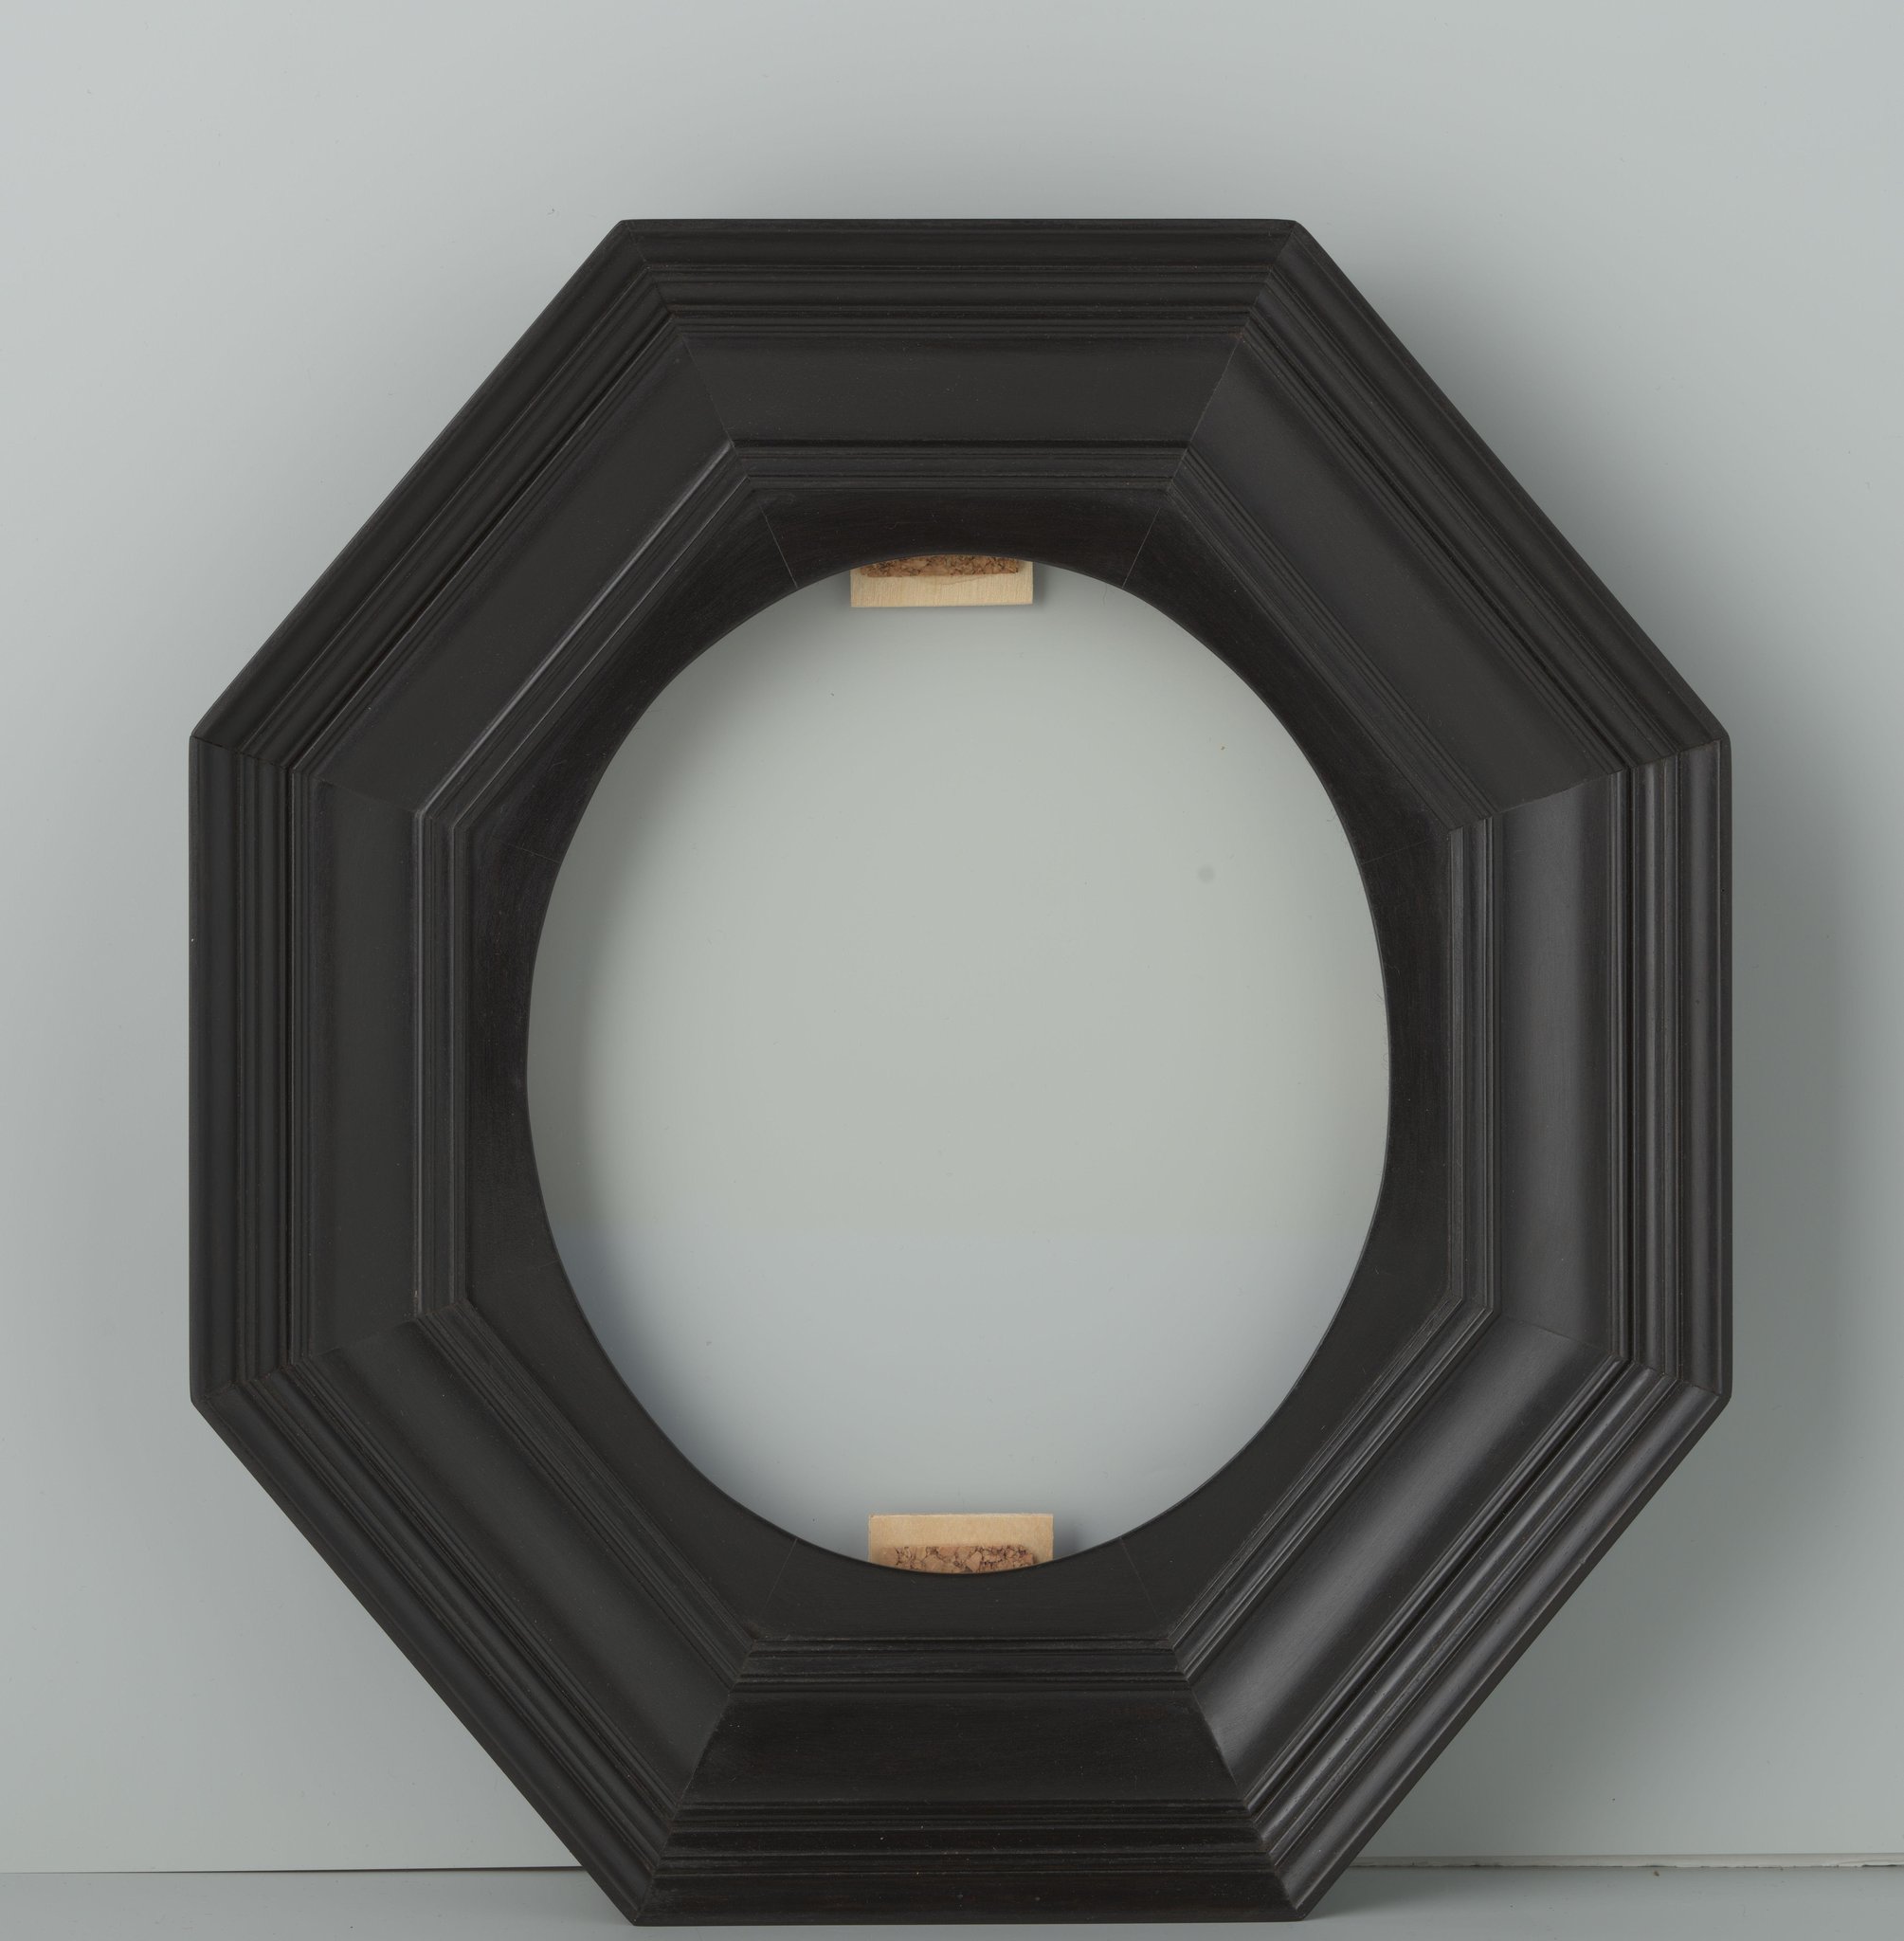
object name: frame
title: Zwarte achthoekige profiellijst met ovalen dagkant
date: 2023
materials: wood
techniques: veneering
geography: haarlem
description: Achthoekige profiellijst met gezwart ebbenhouten fineer en een ovalen dagkant. De grenen zool heeft een halfhoutverbinding. Reproductie van één van oorspronkelijke lijstjes om de zeven portretten van Cornelis Samuelsz/ van Esch en zijn familie (SK-A-1747-A t/m G).